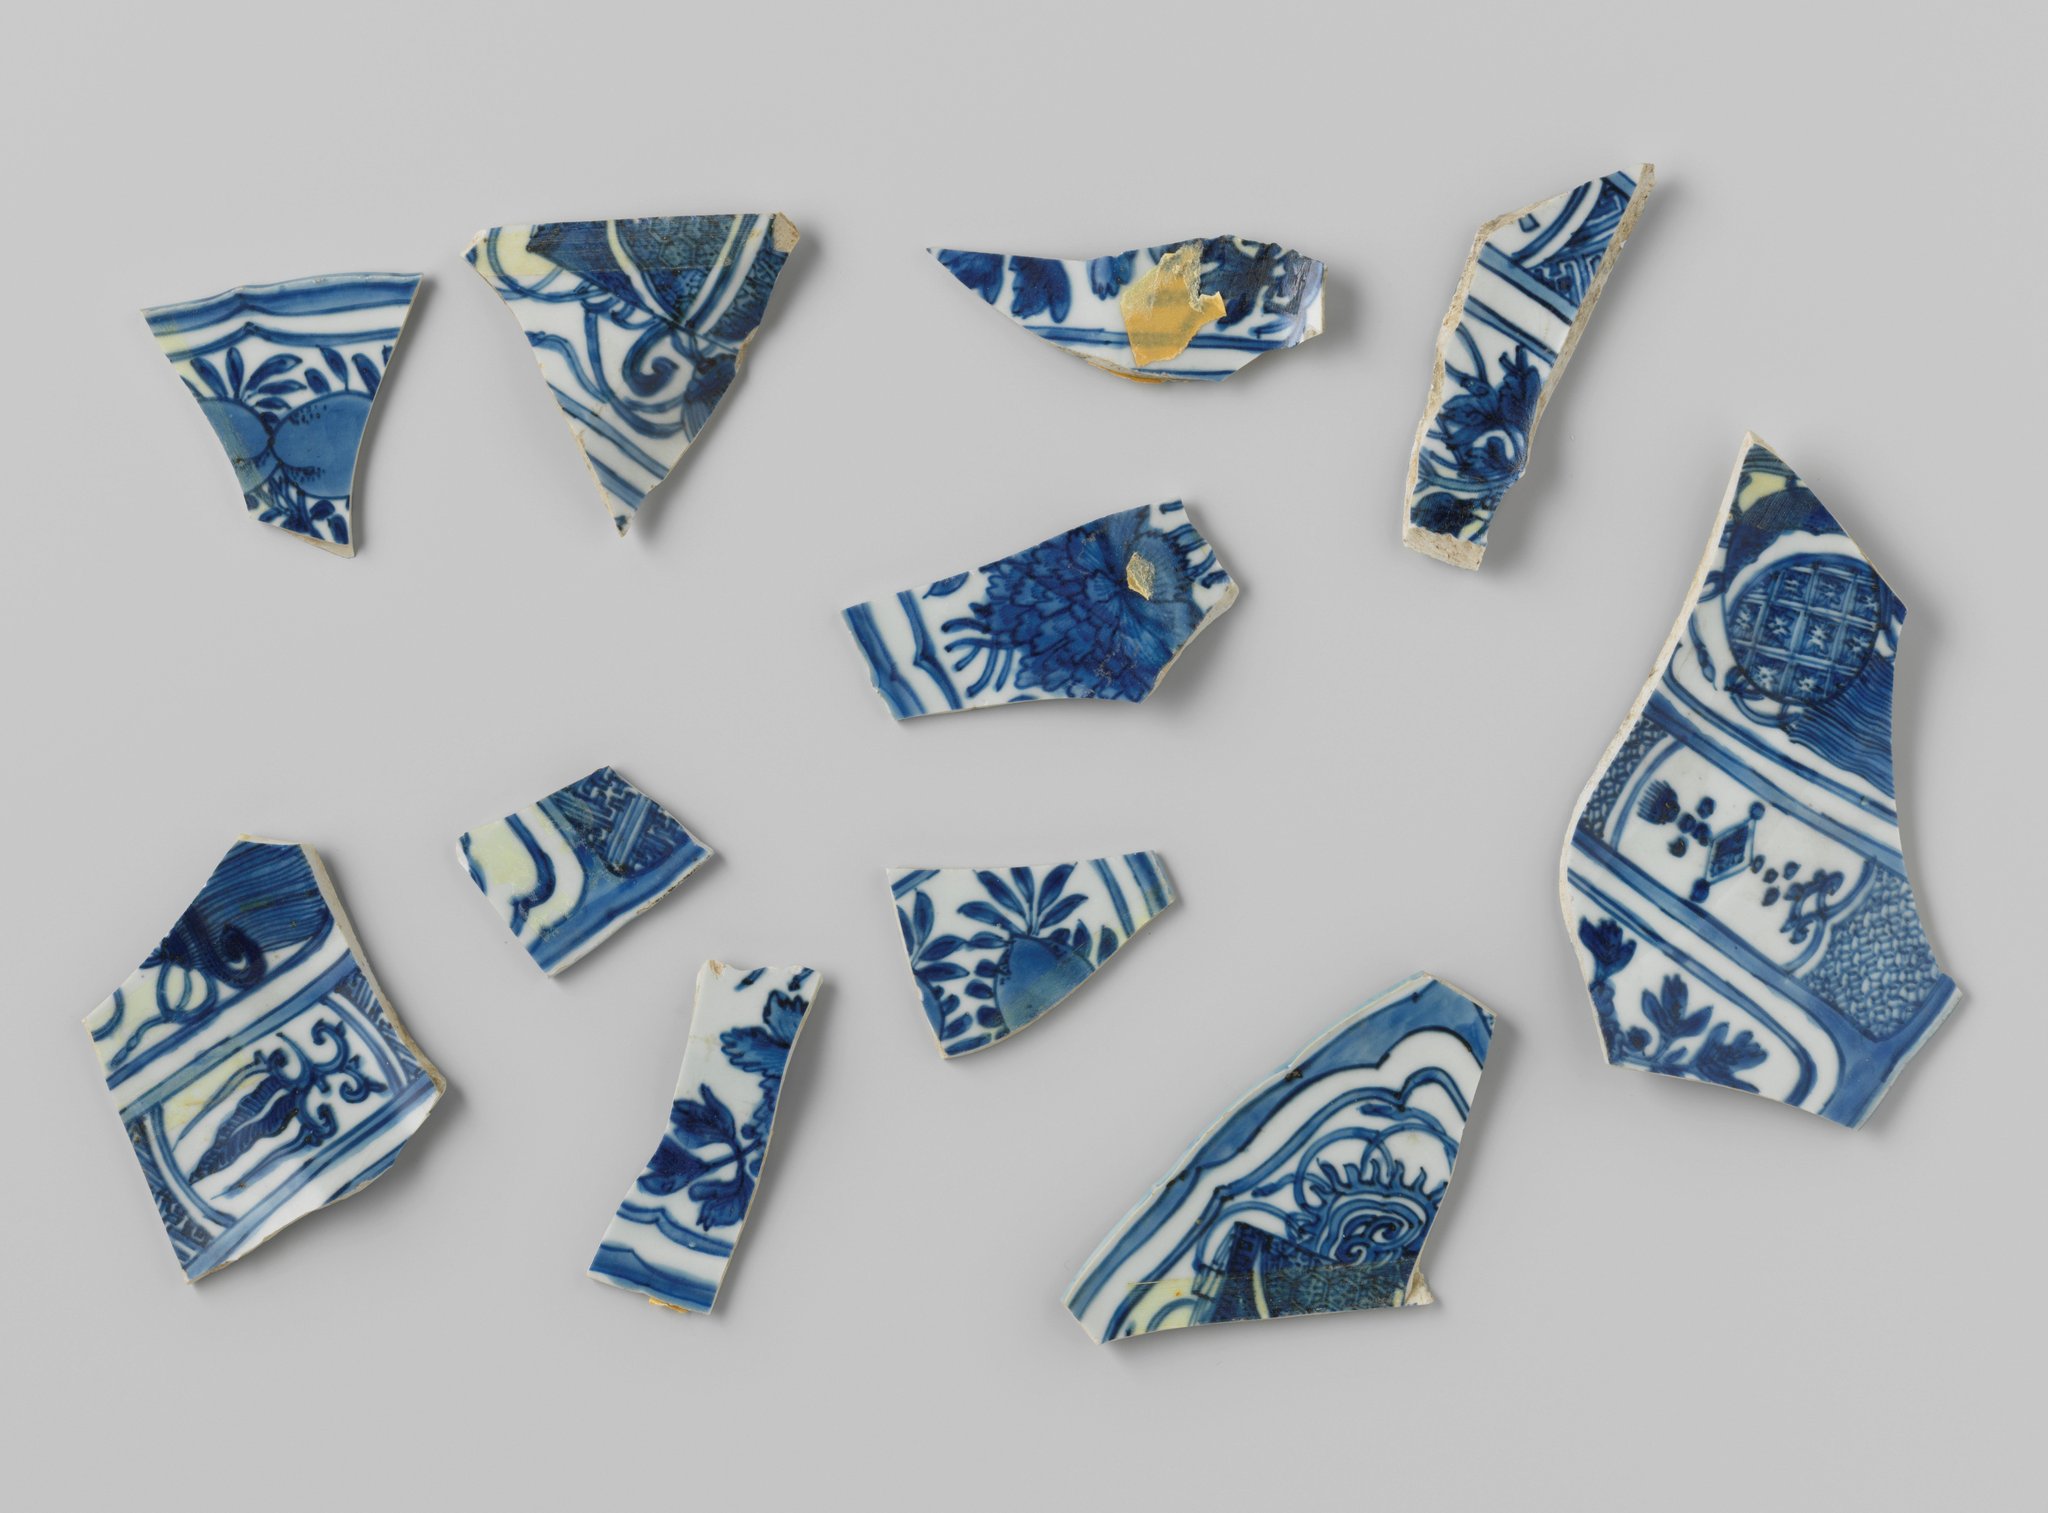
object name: plate dish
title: Scherven van borden uit V.O.C.-schip de 'Witte Leeuw'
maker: Anonymous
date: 1613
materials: bone china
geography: jingdezhen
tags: verenigde oostindische compagnie, sint-helena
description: Scherven van borden uit V.O.C.-schip de 'Witte Leeuw', zak met scherven kraakporselein.